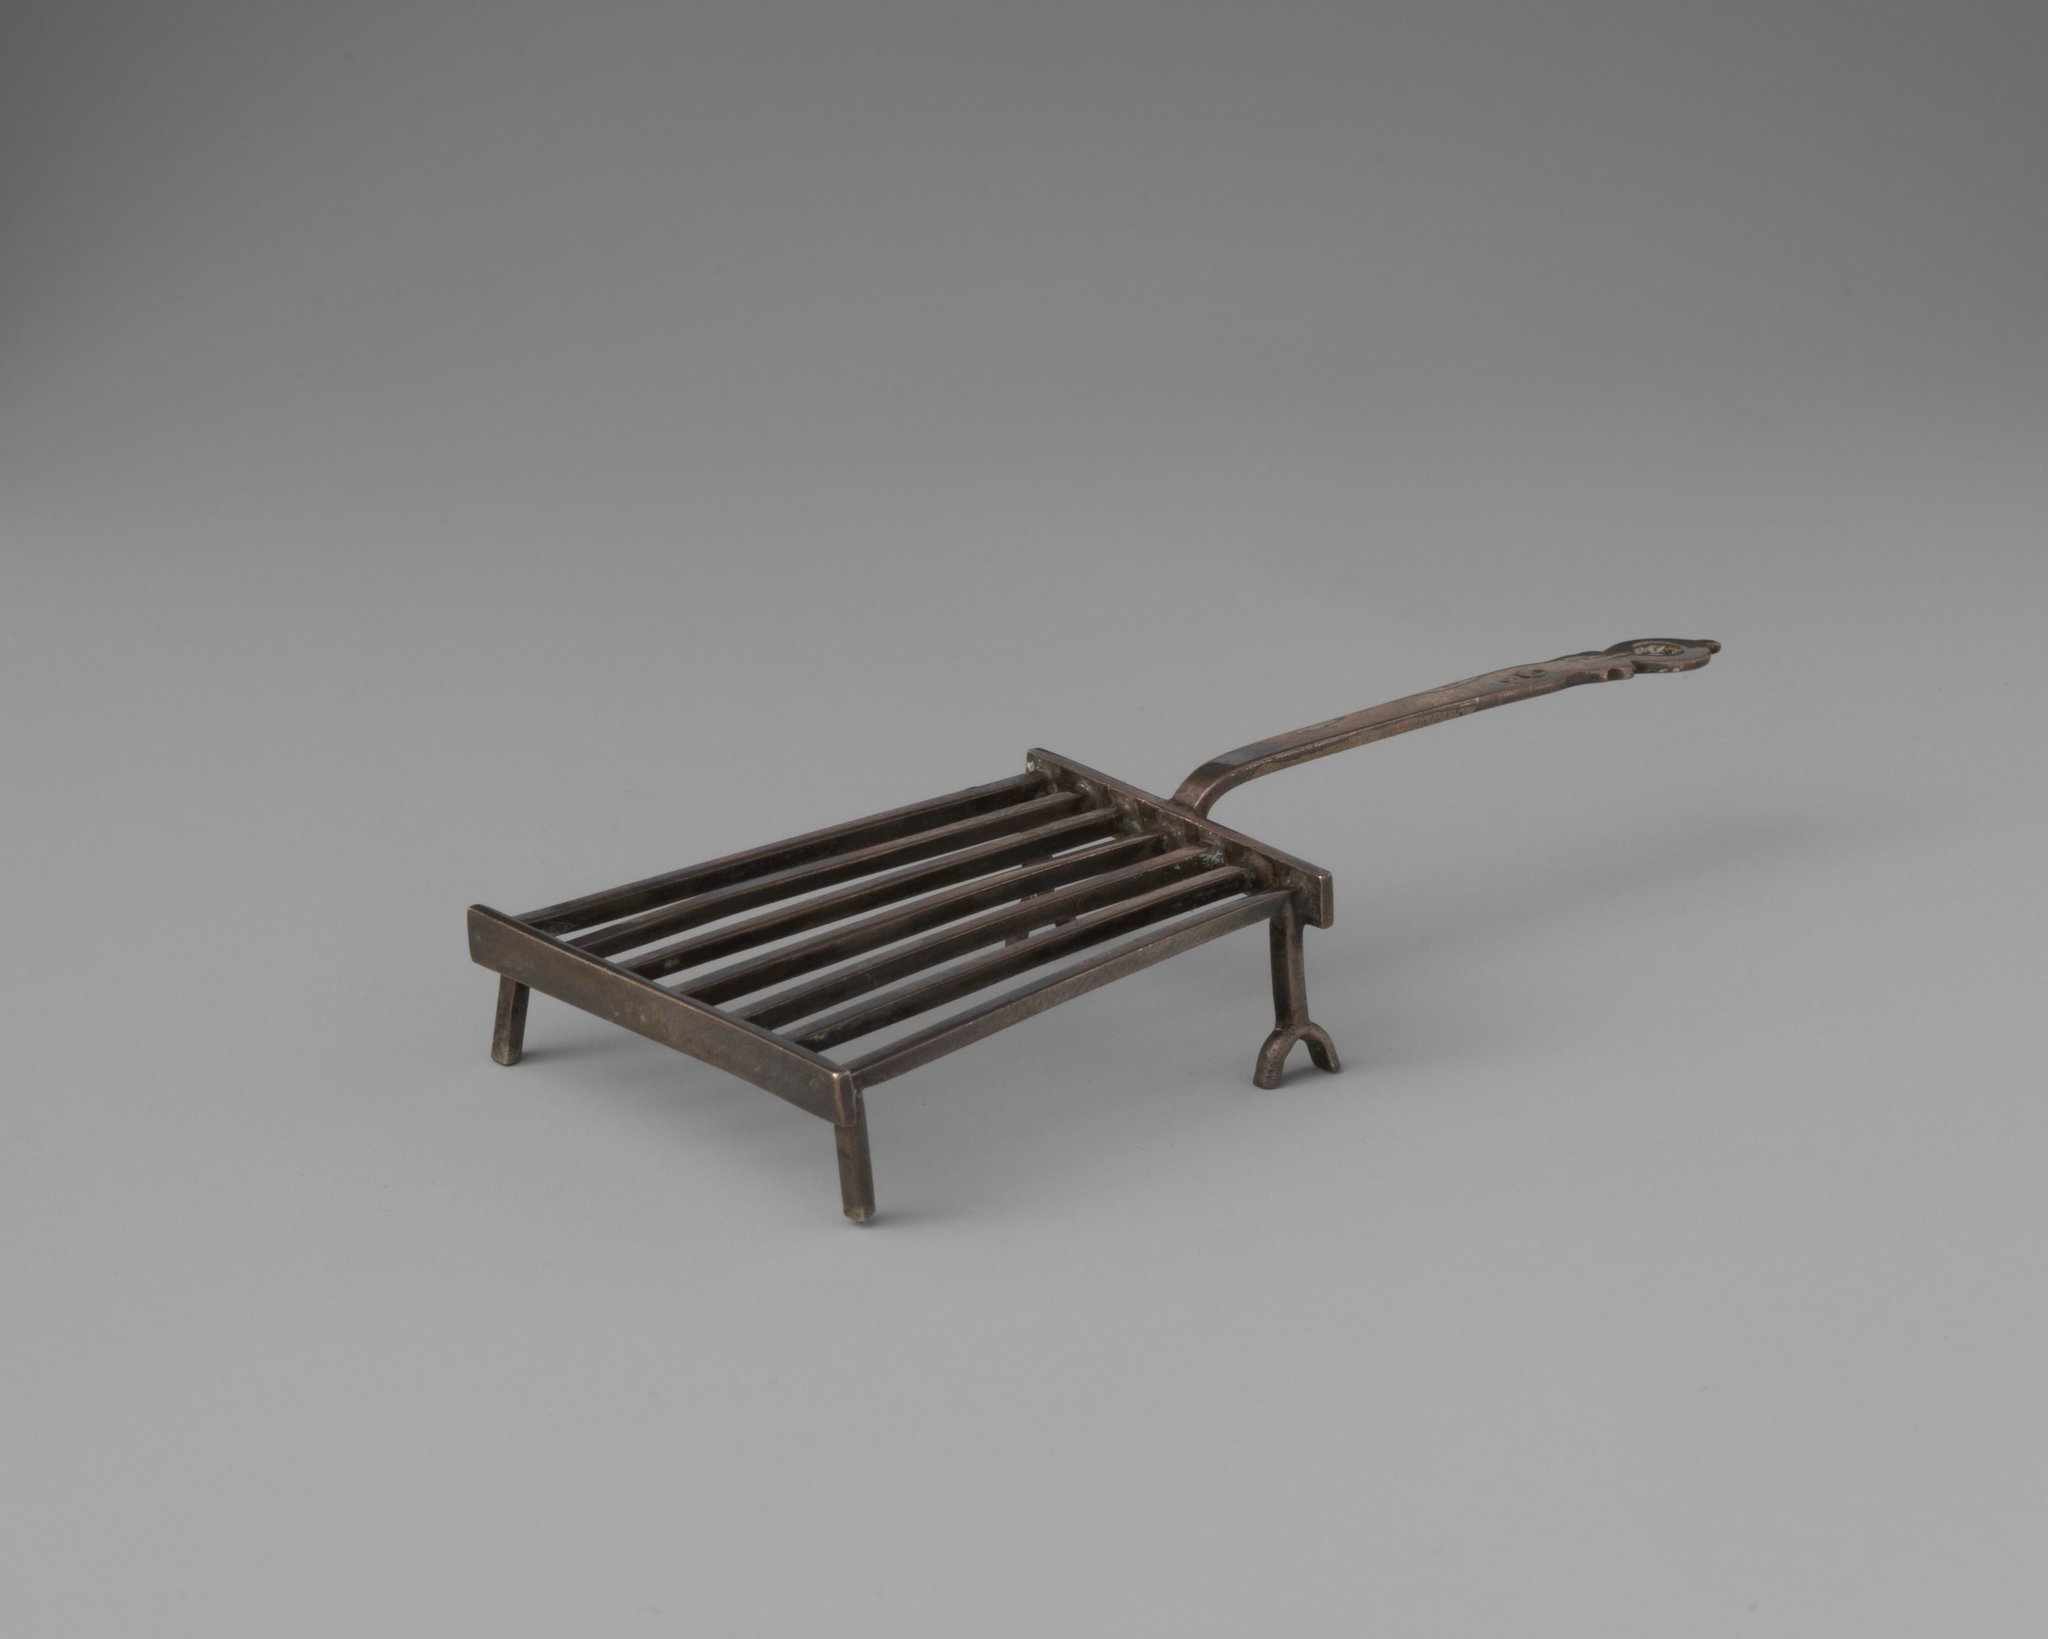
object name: trivet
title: Miniature trivet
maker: david clayton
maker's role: maker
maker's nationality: british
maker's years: 1659-1719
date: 1720-1730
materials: silver